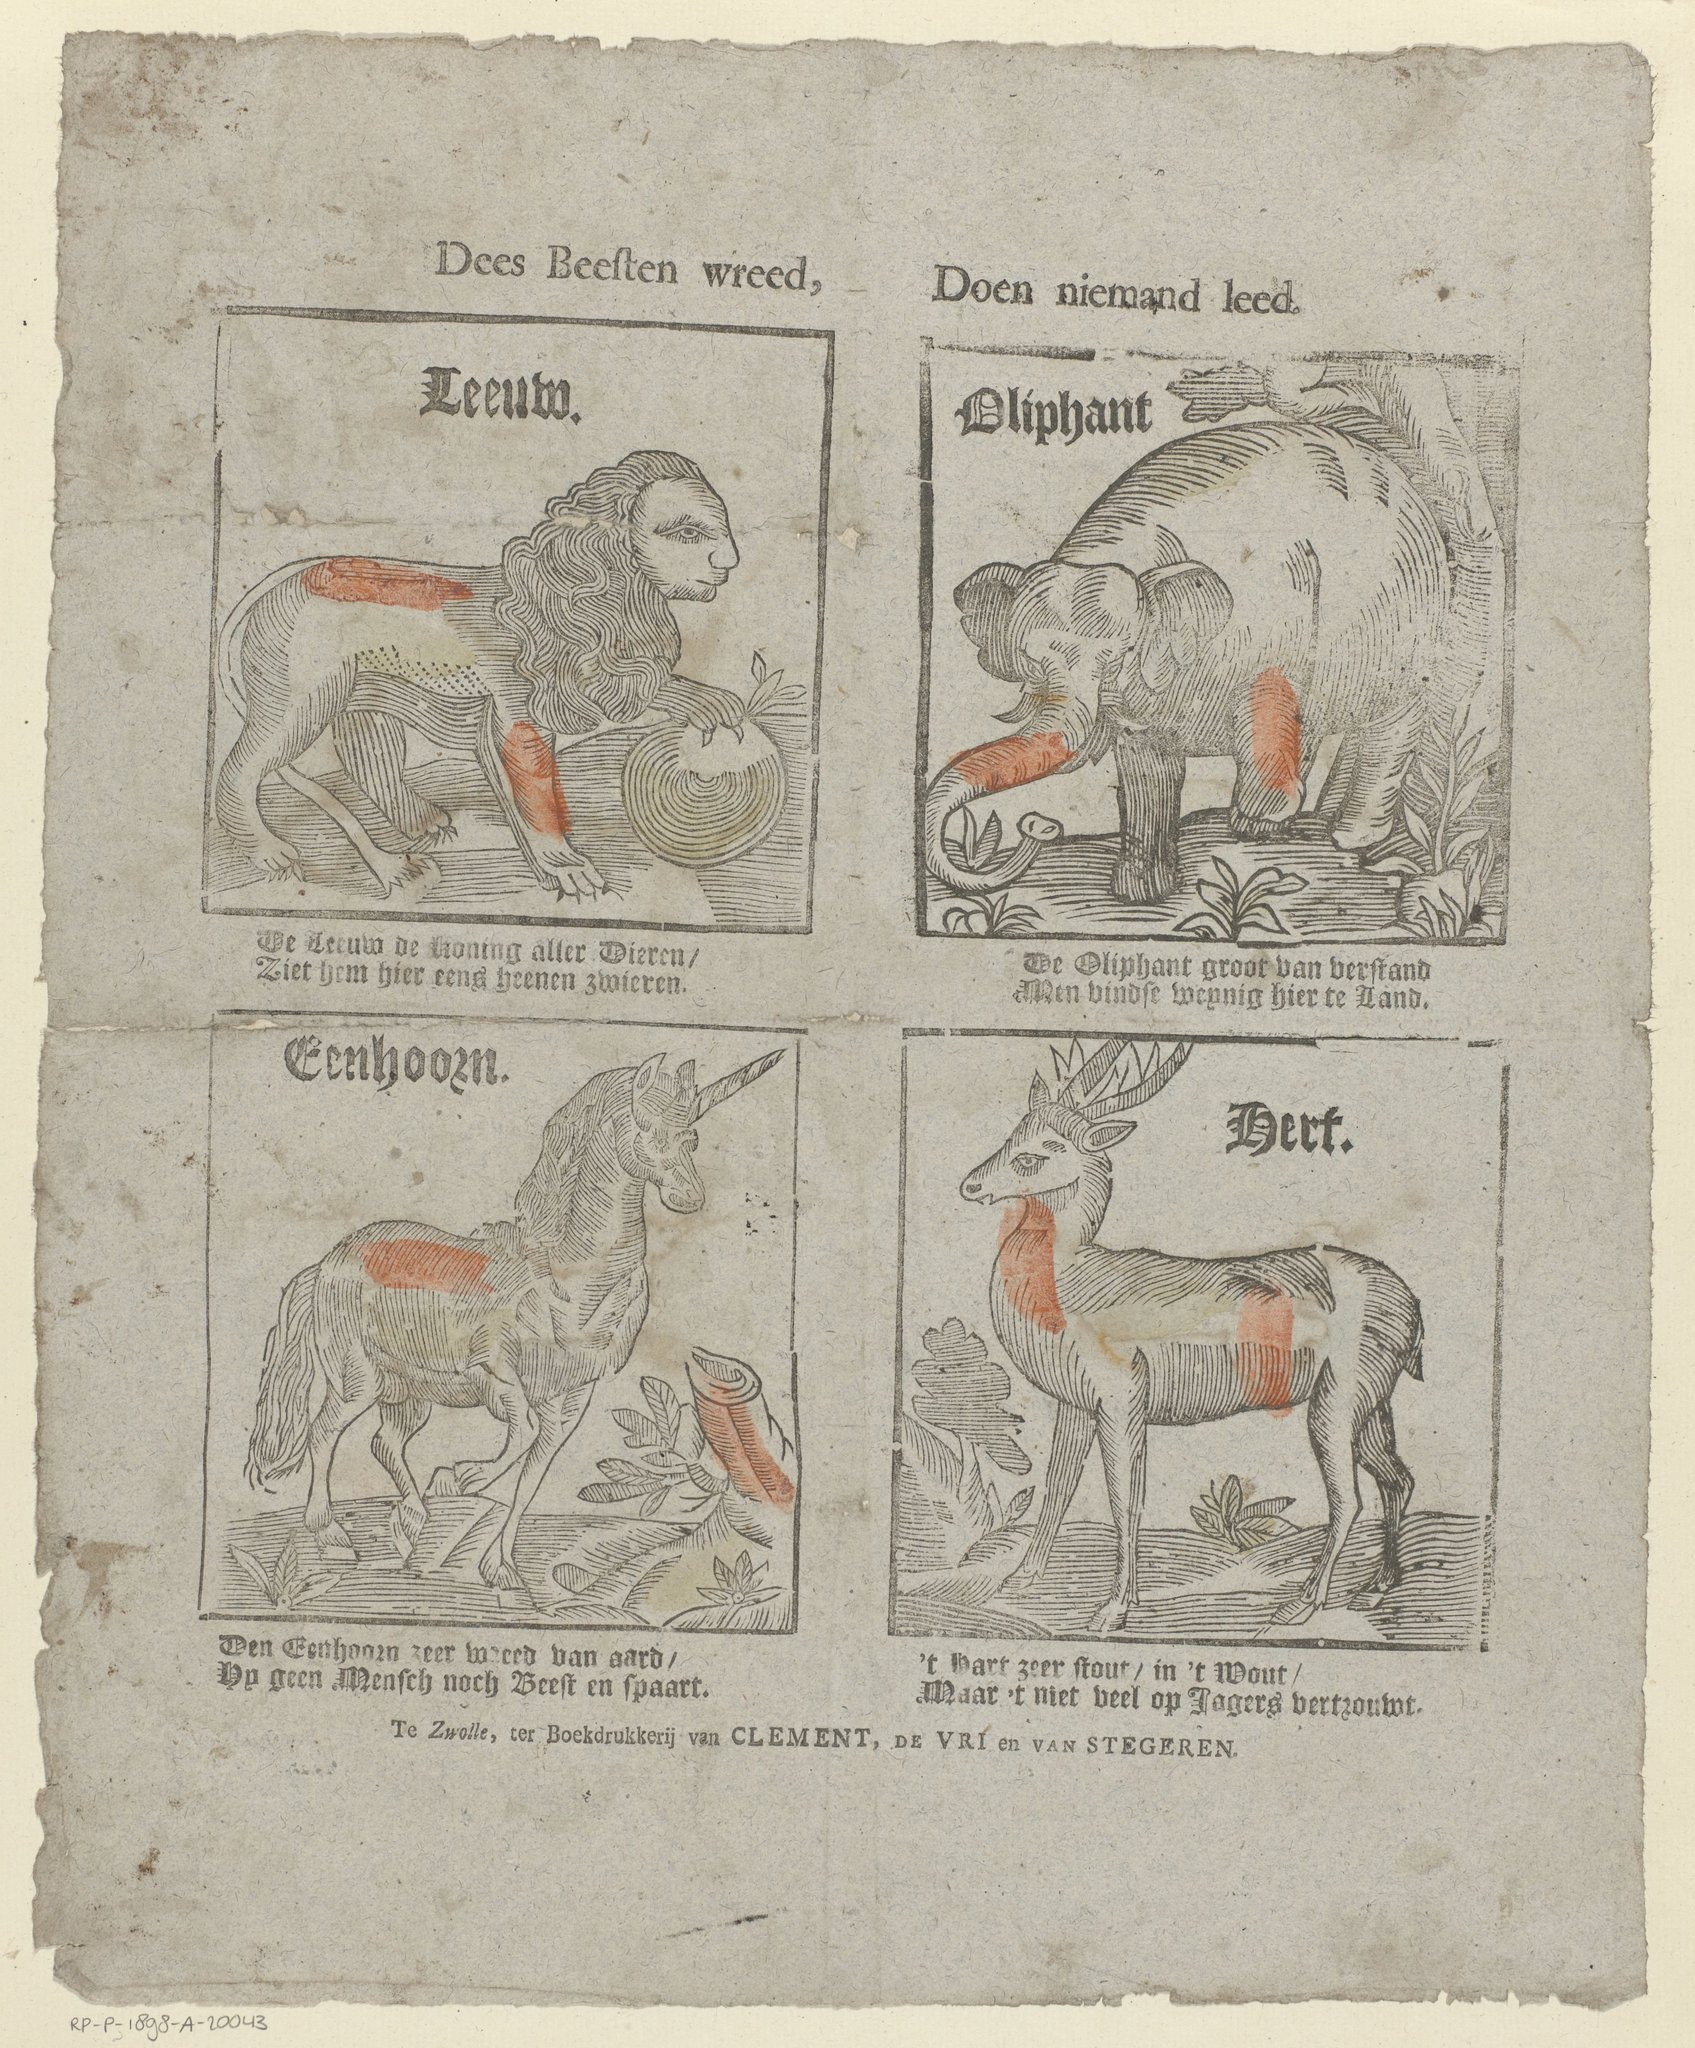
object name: print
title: Dees beesten wreed, doen niemand leed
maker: Anonymous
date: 1816-1836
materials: paper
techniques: colour, letterpress printing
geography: zwolle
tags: hoofed animals: deer, unicorn, beasts of prey, predatory animals: lion, trunked animals: elephant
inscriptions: collector's mark: Lugt 2166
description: Blad met 4 voorstellingen van dieren: een leeuw, een olifant, een eenhoorn en een hert. Onder elke voorstelling een tweeregelig vers.